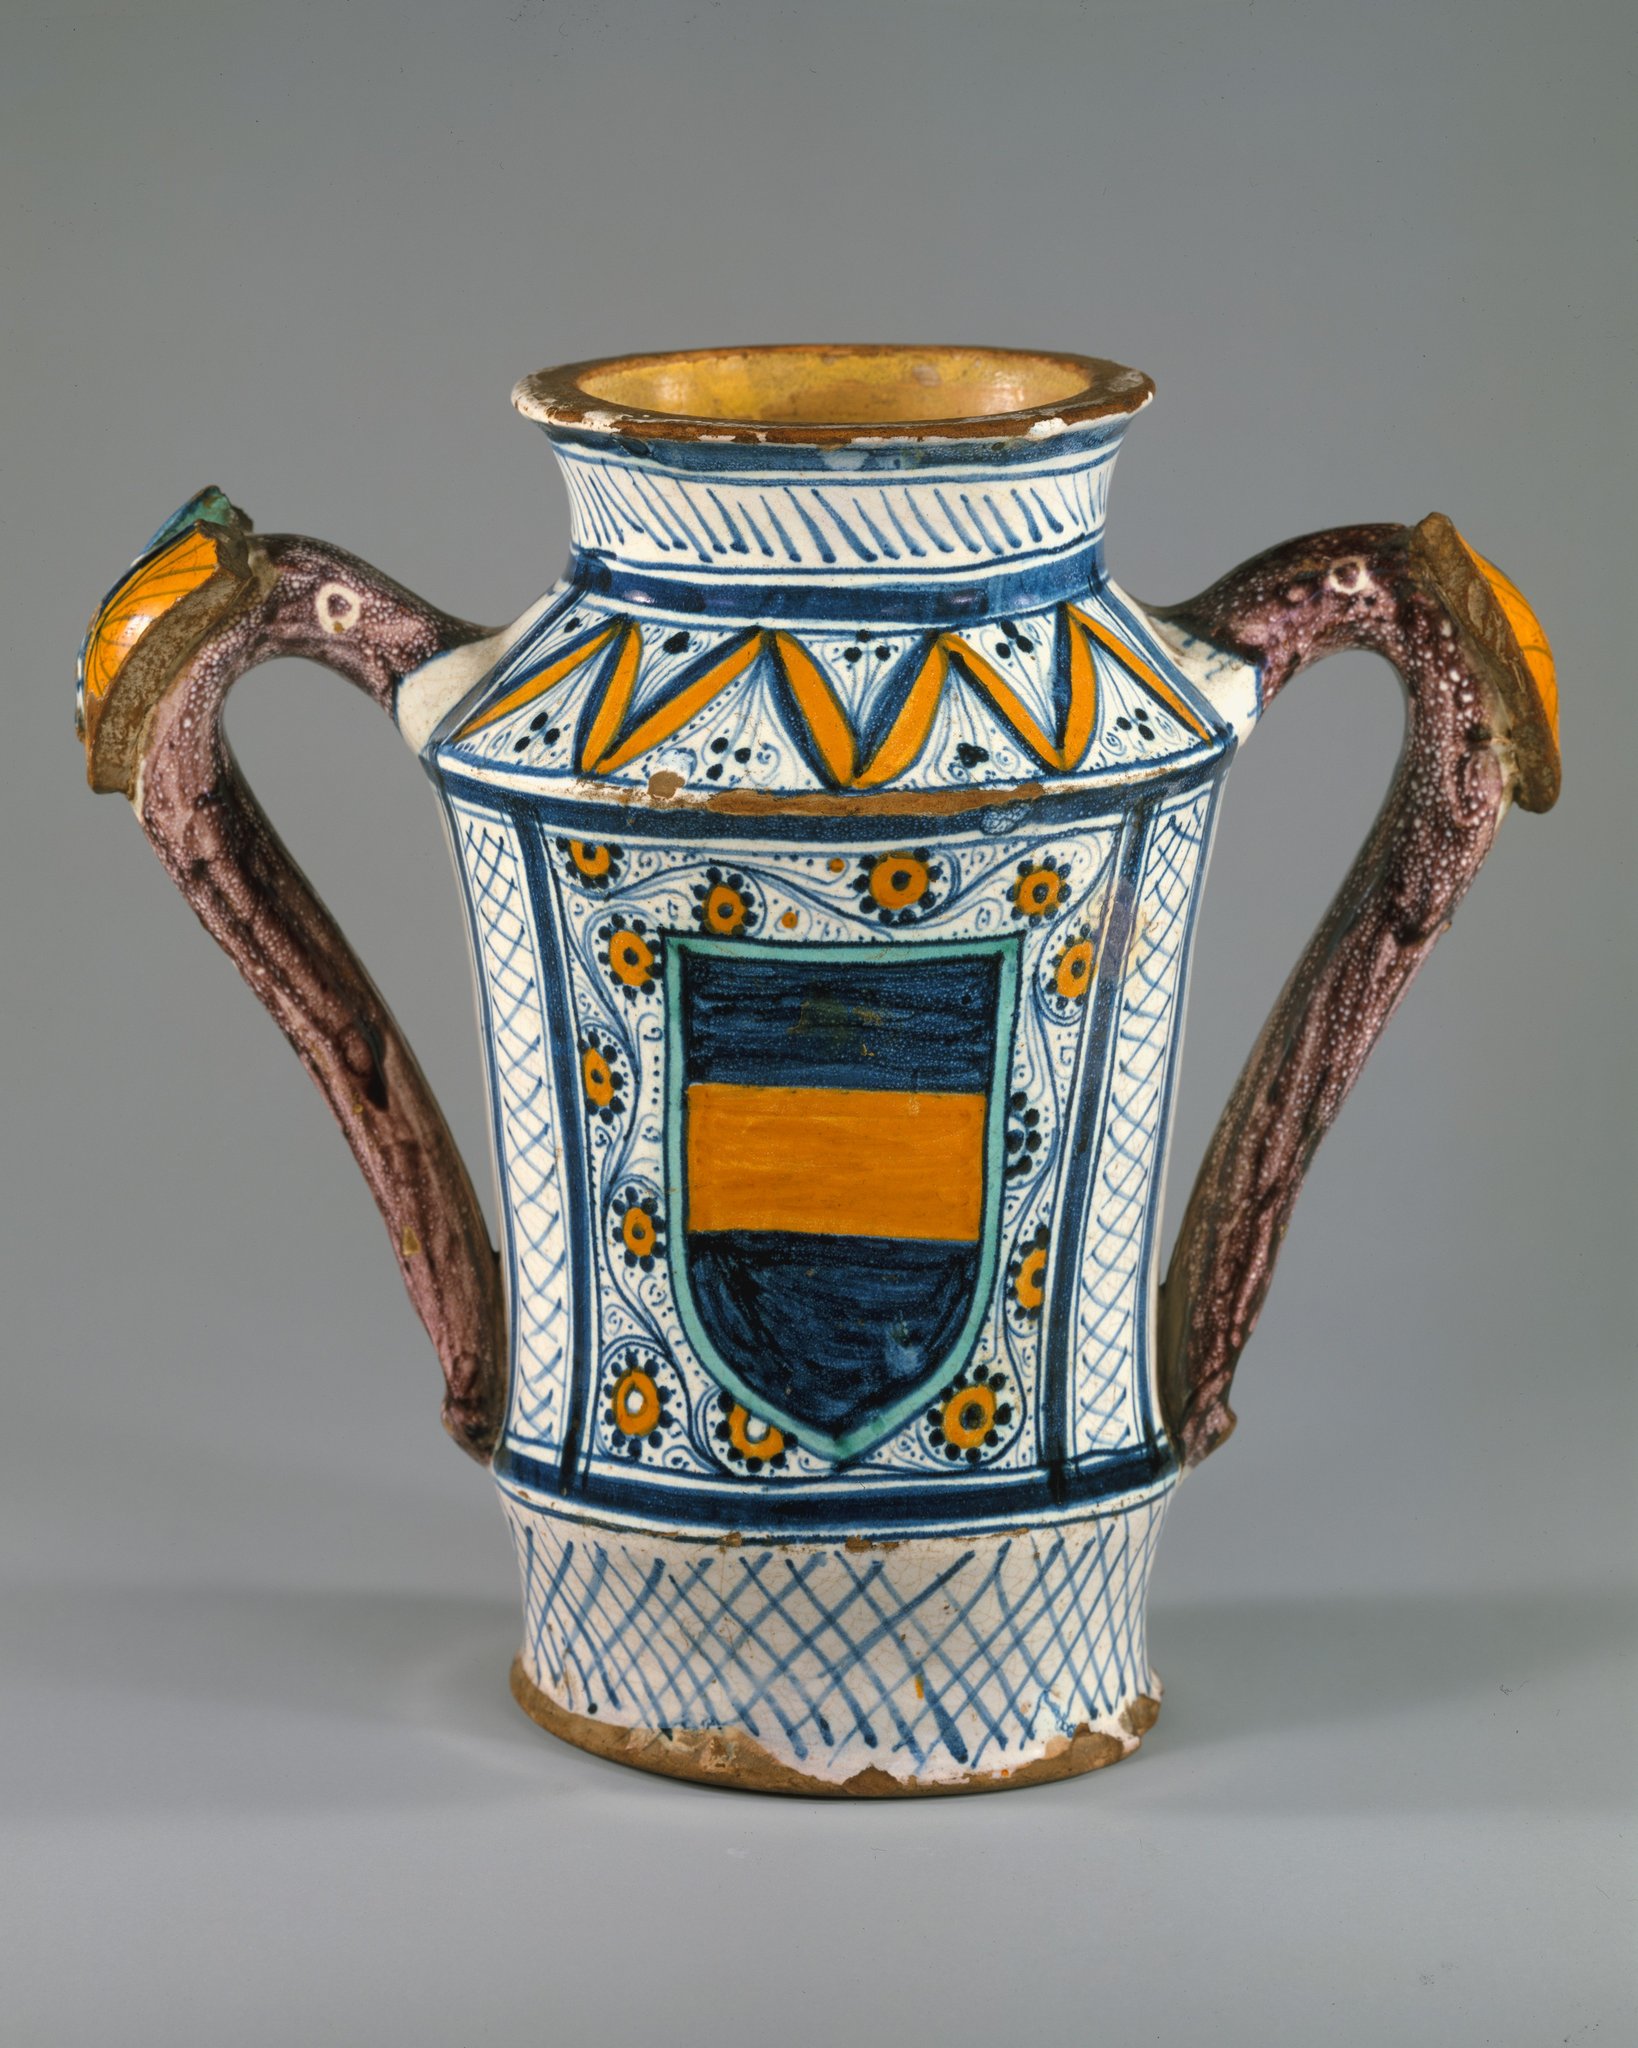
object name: albarello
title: Apothecary jar (albarello)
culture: italian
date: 1480-1490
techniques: maiolica, glazing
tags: coat of arms